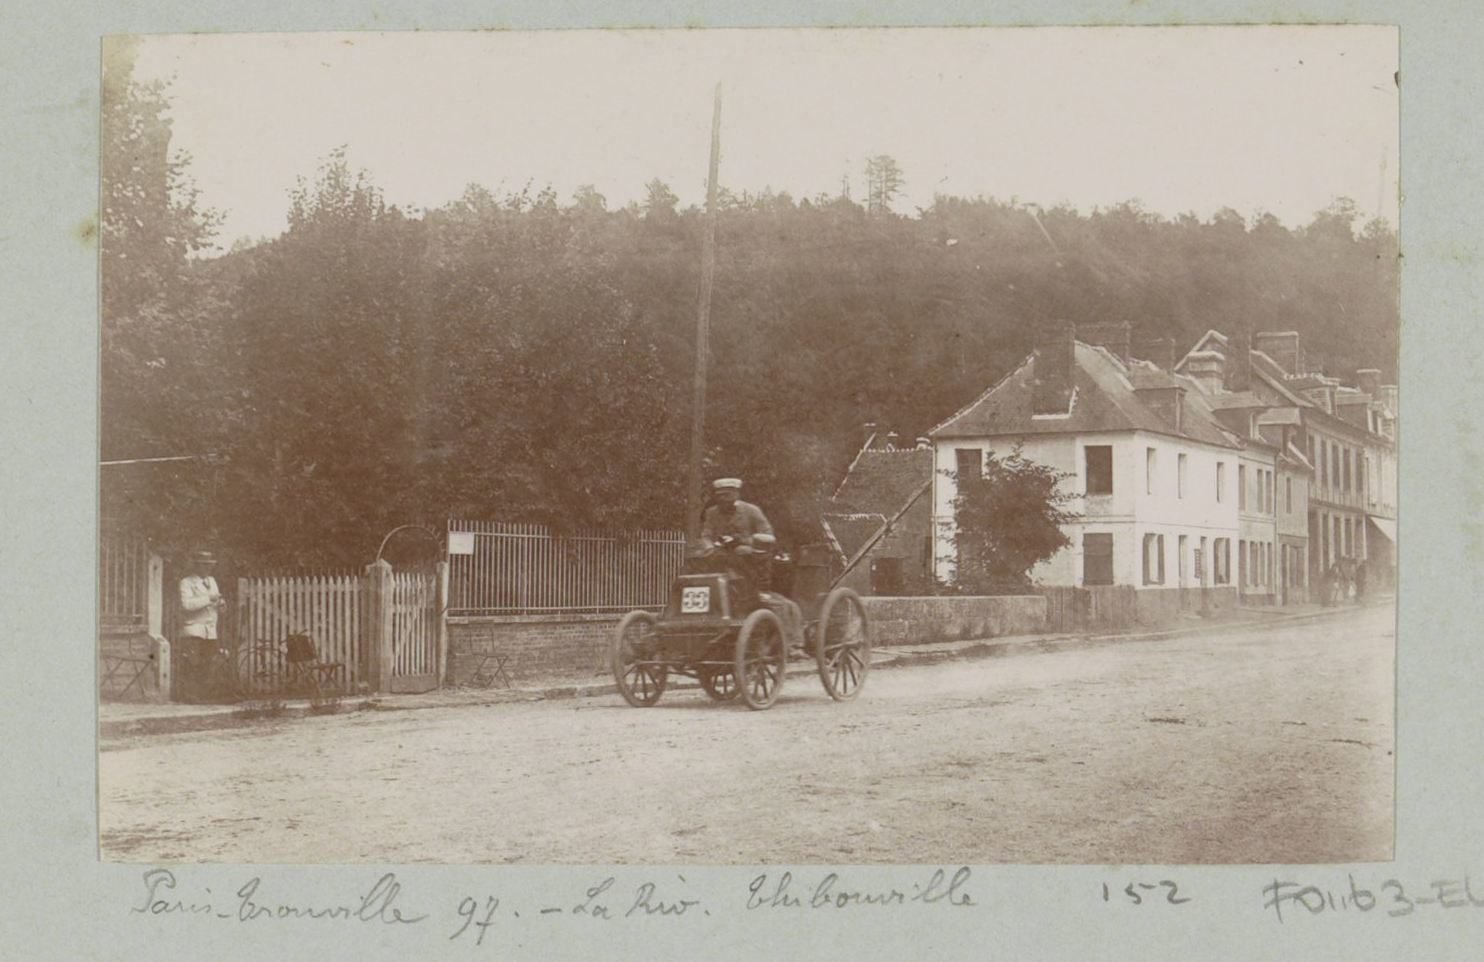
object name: photograph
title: Automobiel op een weg in Thibouville, vermoedelijk tijdens een autorace van Parijs naar Trouville-sur-Mer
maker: delizy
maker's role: manufacturer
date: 1897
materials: paper, photographic support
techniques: gelatin silver print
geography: thibouville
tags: motorcar racing, automobile, public road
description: Onderdeel van Fotoalbum van een Franse amateurfotograaf met opnames van uitstapjes in Frankrijk, Spanje, België, Luxemburg en Nederland, de eerste automobielen en autoraces.